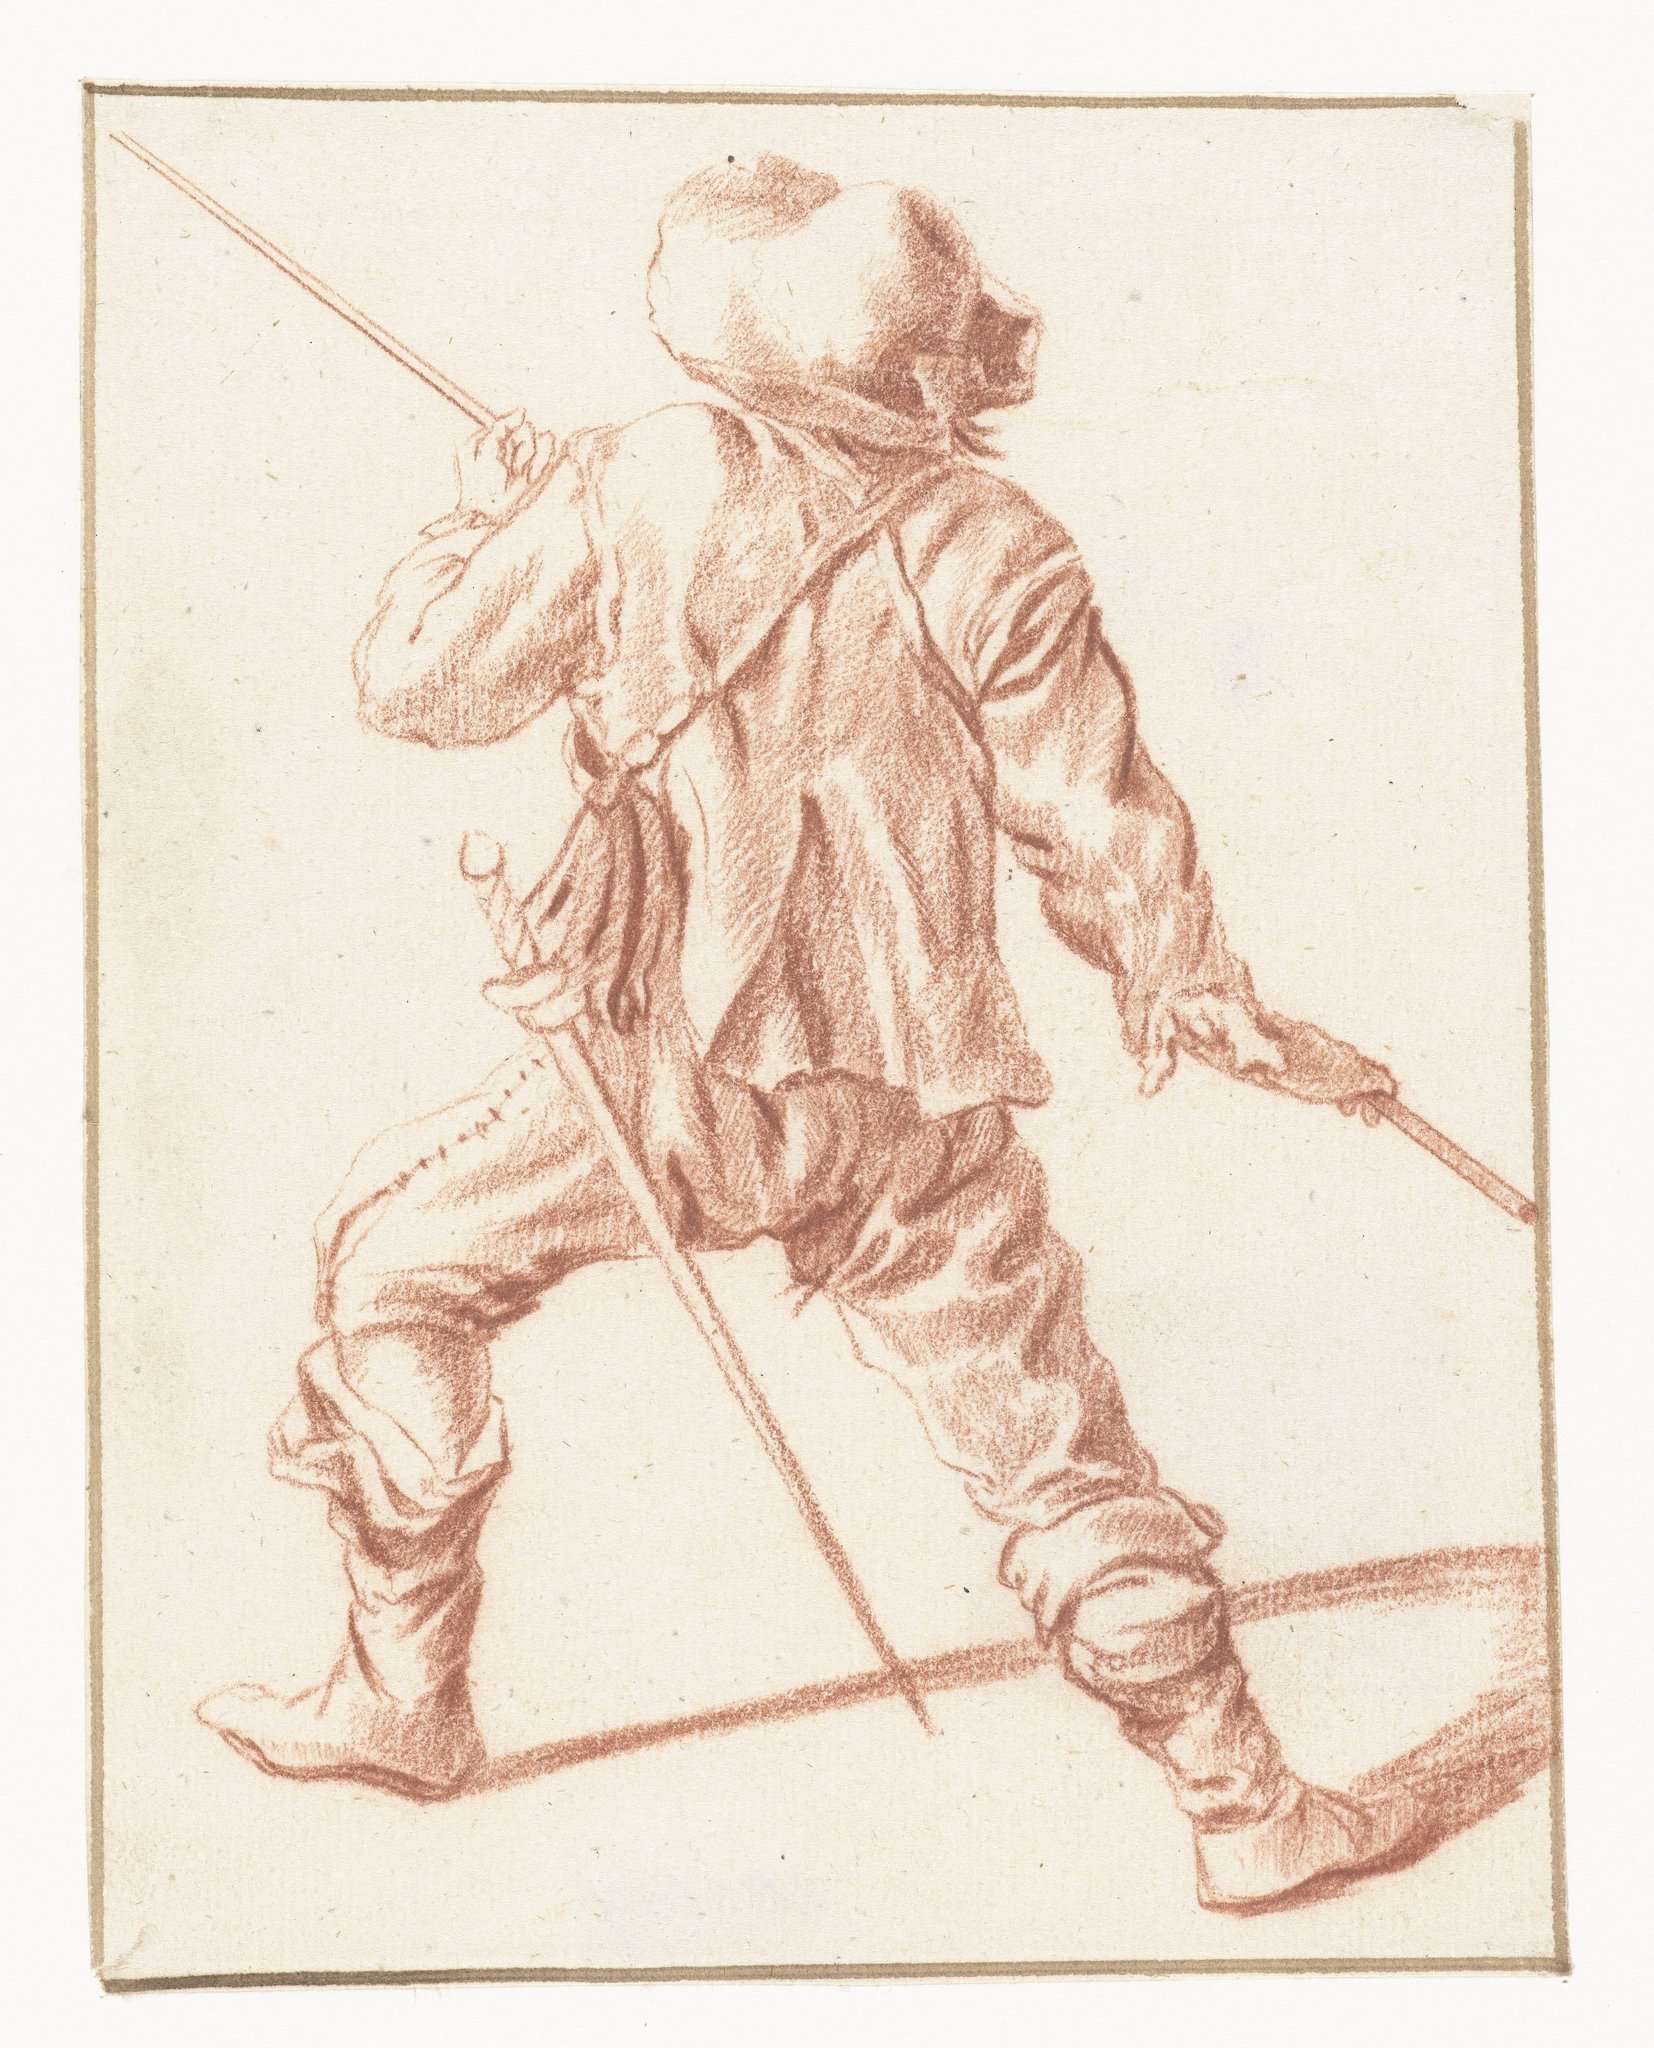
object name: drawing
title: Man Fighting with a Lance, Seen from Behind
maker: Anonymous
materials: chalk, paper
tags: helved weapons, polearms (for striking, hacking, thrusting): lance (+ handling of weapons)